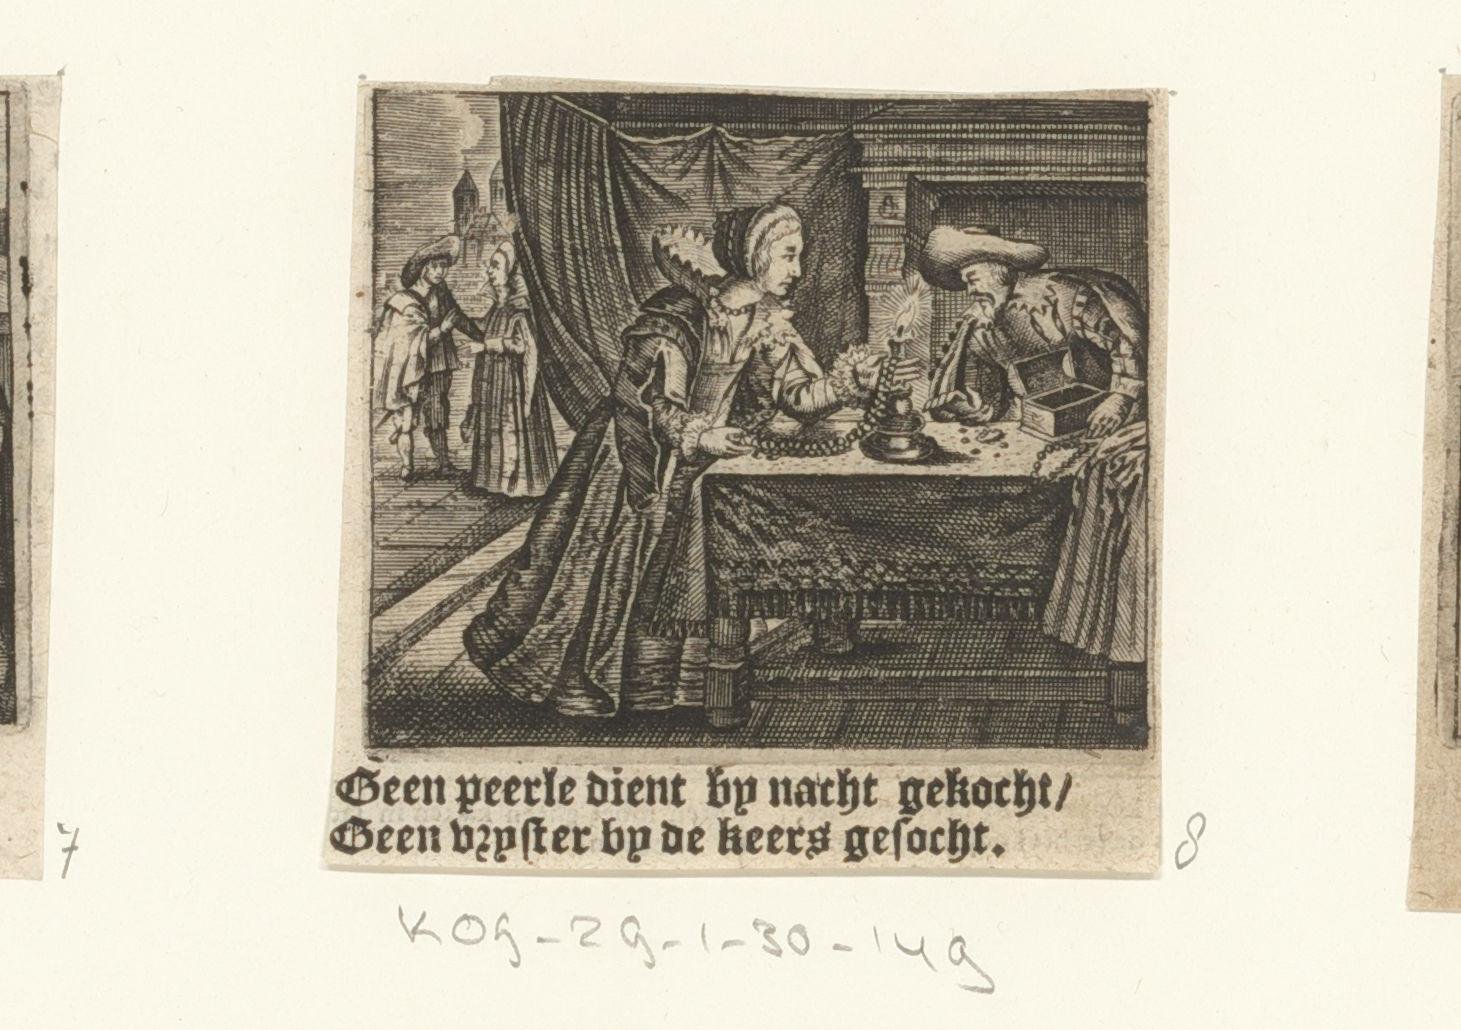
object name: print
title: Geen peerle dient bij nacht gekocht / Geen vrijster bij de keers gesocht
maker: Anonymous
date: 1635-1715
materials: paper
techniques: engraving, letterpress printing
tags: examining merchandise, dark room, proverbs, sayings, etc., candle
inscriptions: collector's mark: Lugt 1641, stamp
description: Veel versies van dit embleem verschenen in verschillende uitgave van Spiegel van den Ouden ende Nieuwen Tydt. Zoals: Cats, Jacob. Spiegel van den Ouden ende Nieuwen-tijt, Bestaende uyt Spreeck-woorden (...). Dordrecht: Jacob Braat, 1647. Maar ook in andere publicaties (1665, 1671, 1715, 1722).